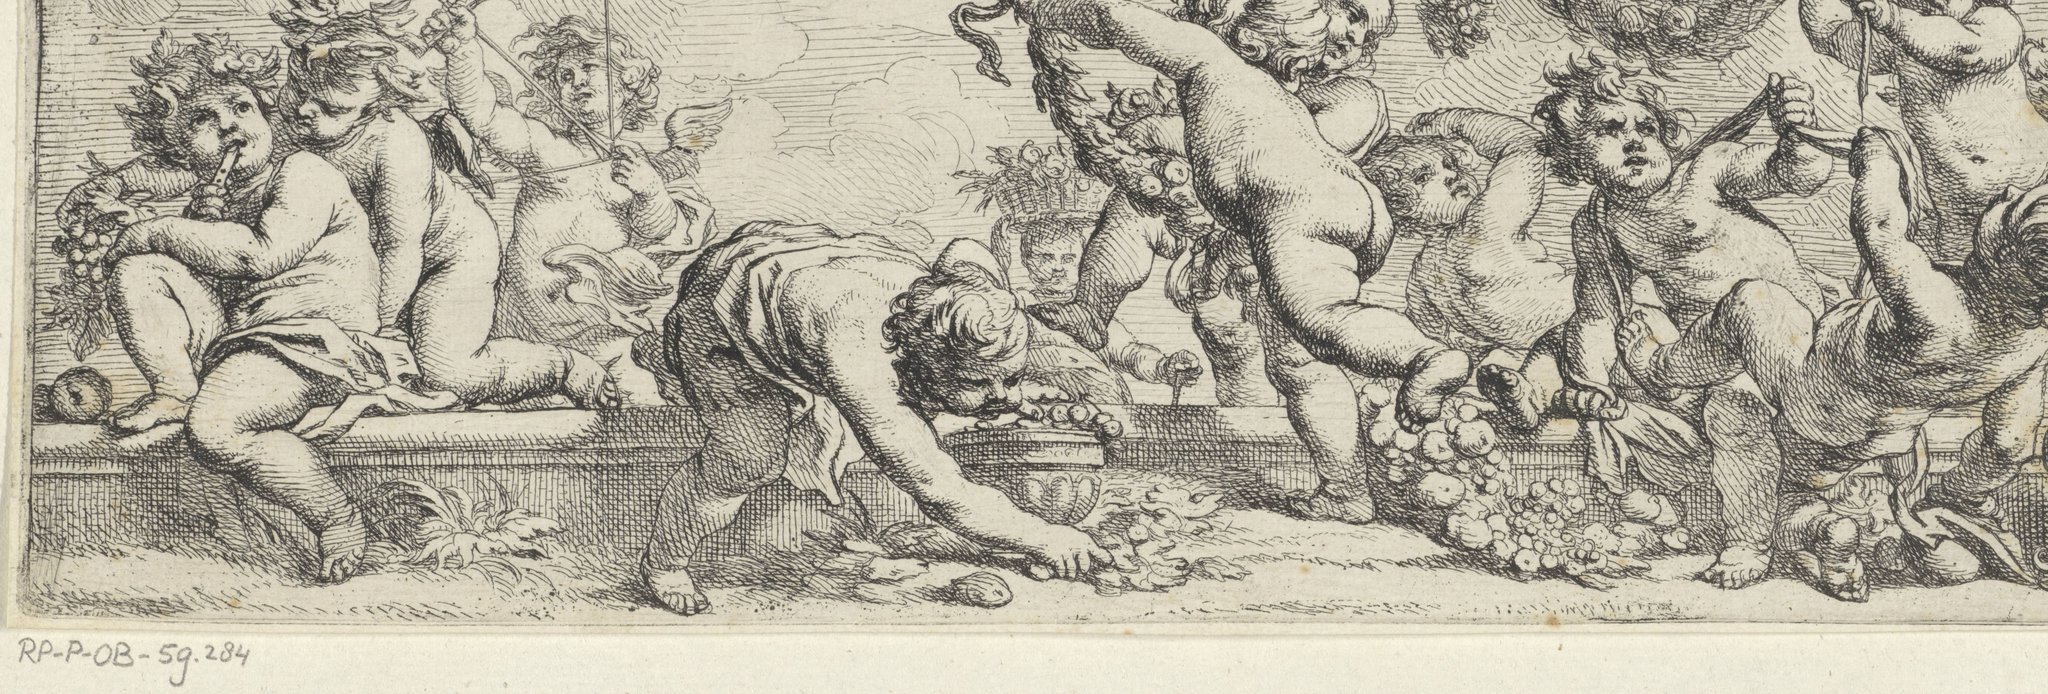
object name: print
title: Fries met spelende kinderen en putti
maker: cornelis schut (i)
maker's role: draughtsman, print maker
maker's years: 1597-1655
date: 1618-1655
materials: paper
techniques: engraving, etching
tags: children's games and plays, attributes of cupid: bow and arrow, cupids: 'amores', 'amoretti', 'putti'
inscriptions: collector's mark: Lugt 240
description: Fries met negen naakte, spelende kinderen. Zij houden guirlandes en banderollen vast. Links drie putti: een met pijl en boog en een met een fluit.